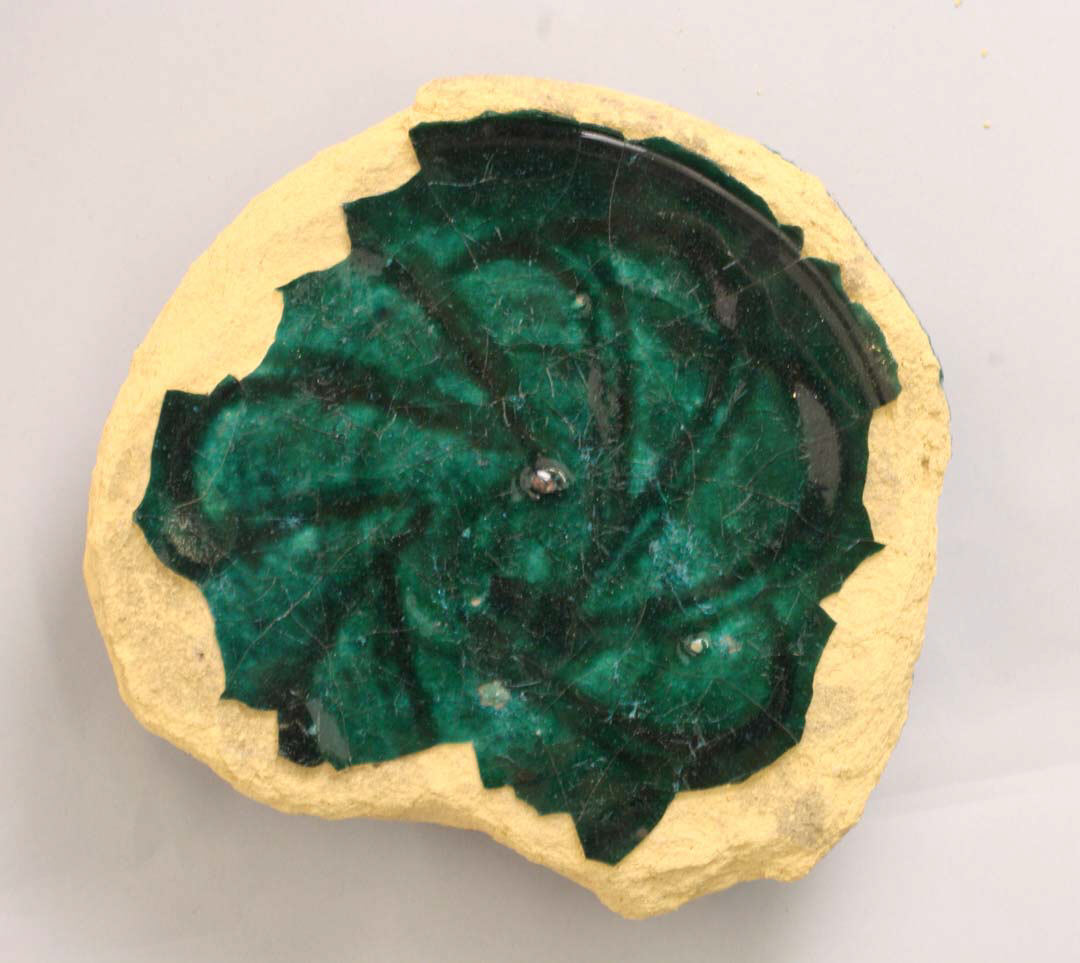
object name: fragment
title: Fragment of a Bowl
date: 1201-1400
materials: earthenware, glaze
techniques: incising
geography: egypt